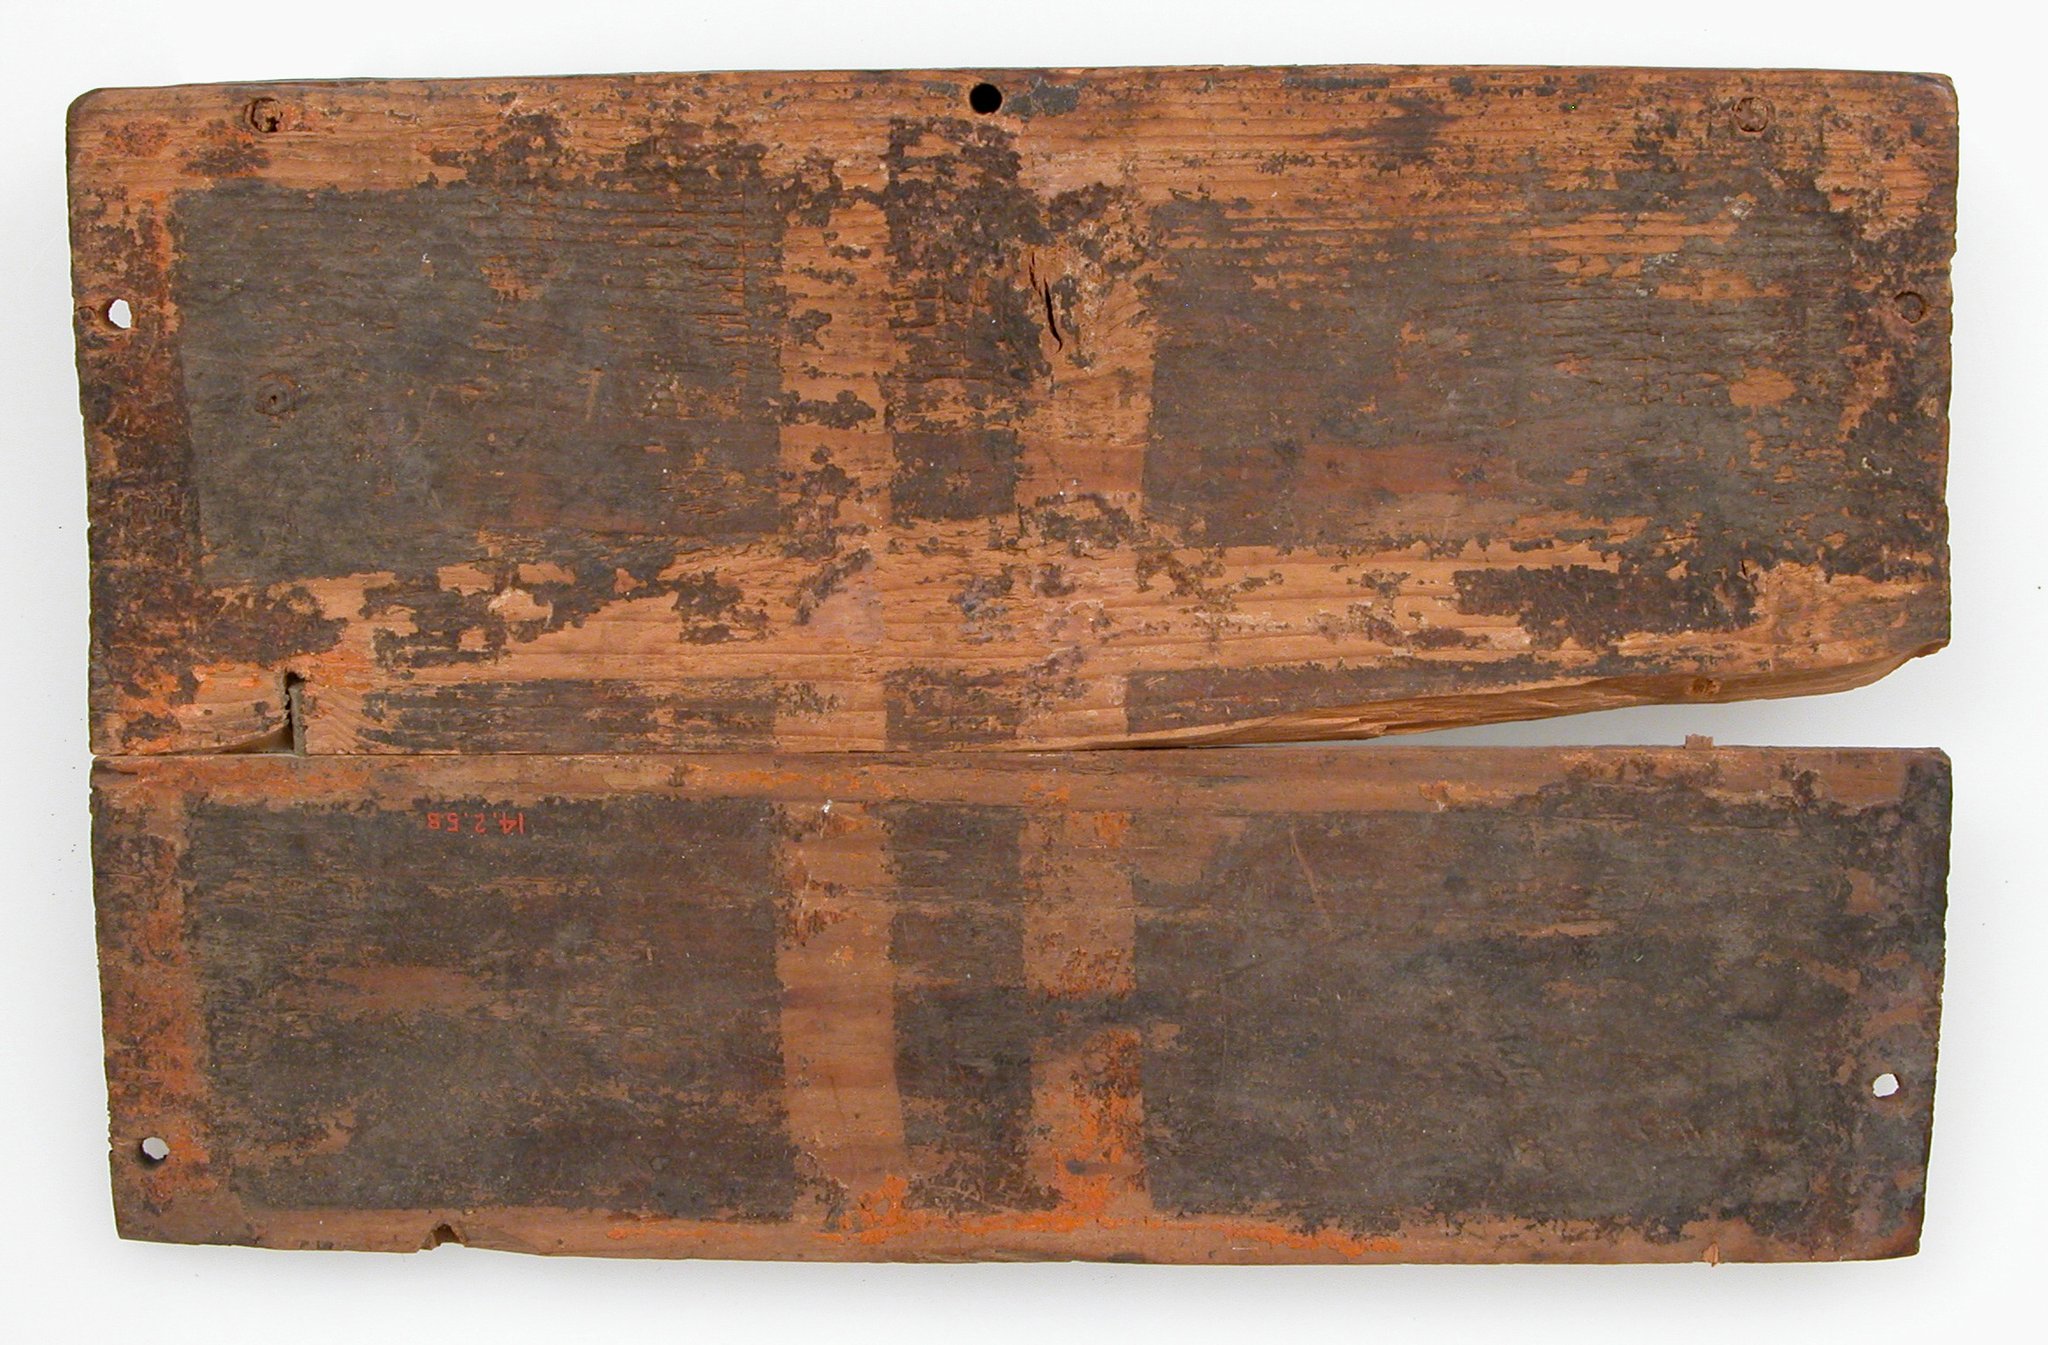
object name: box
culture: coptic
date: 580-640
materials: wood, paint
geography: egypt